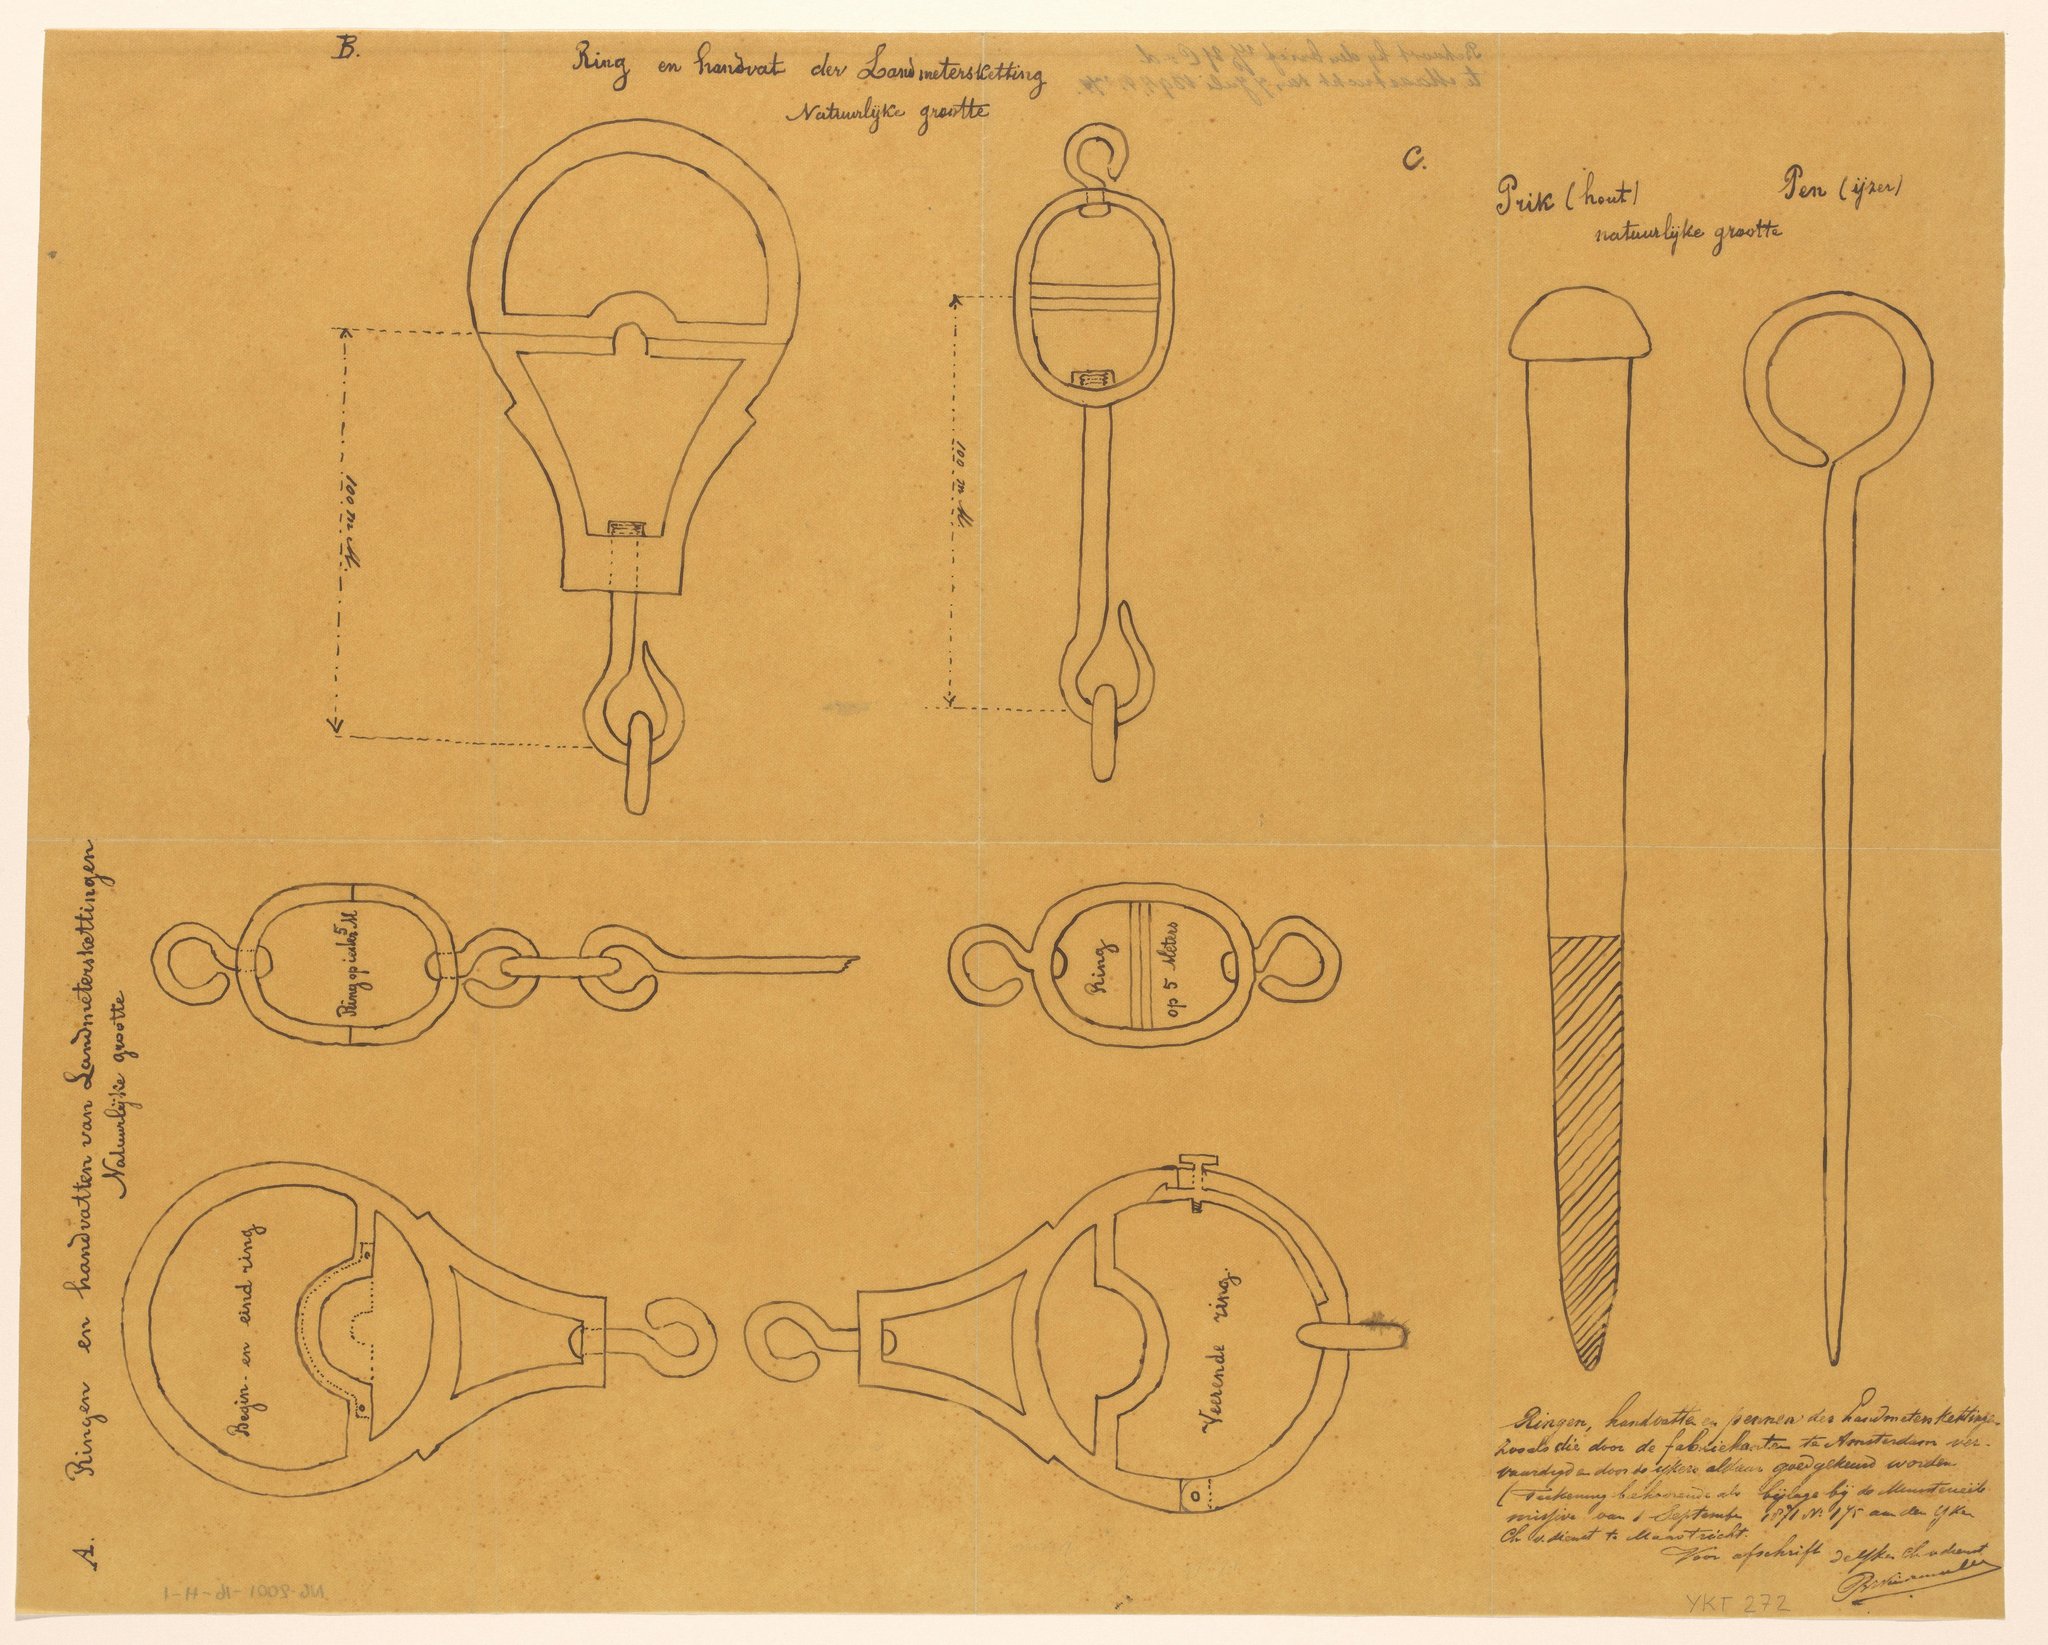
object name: drawing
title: Ringen, handvatten en pennen der landmeterskettingen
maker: Anonymous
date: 1879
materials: ink, paper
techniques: writing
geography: amsterdam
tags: netherlands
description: Technische tekening met 8 details van een landmetersketting. Met aantekeningen met pen uit 7 juli 1894.